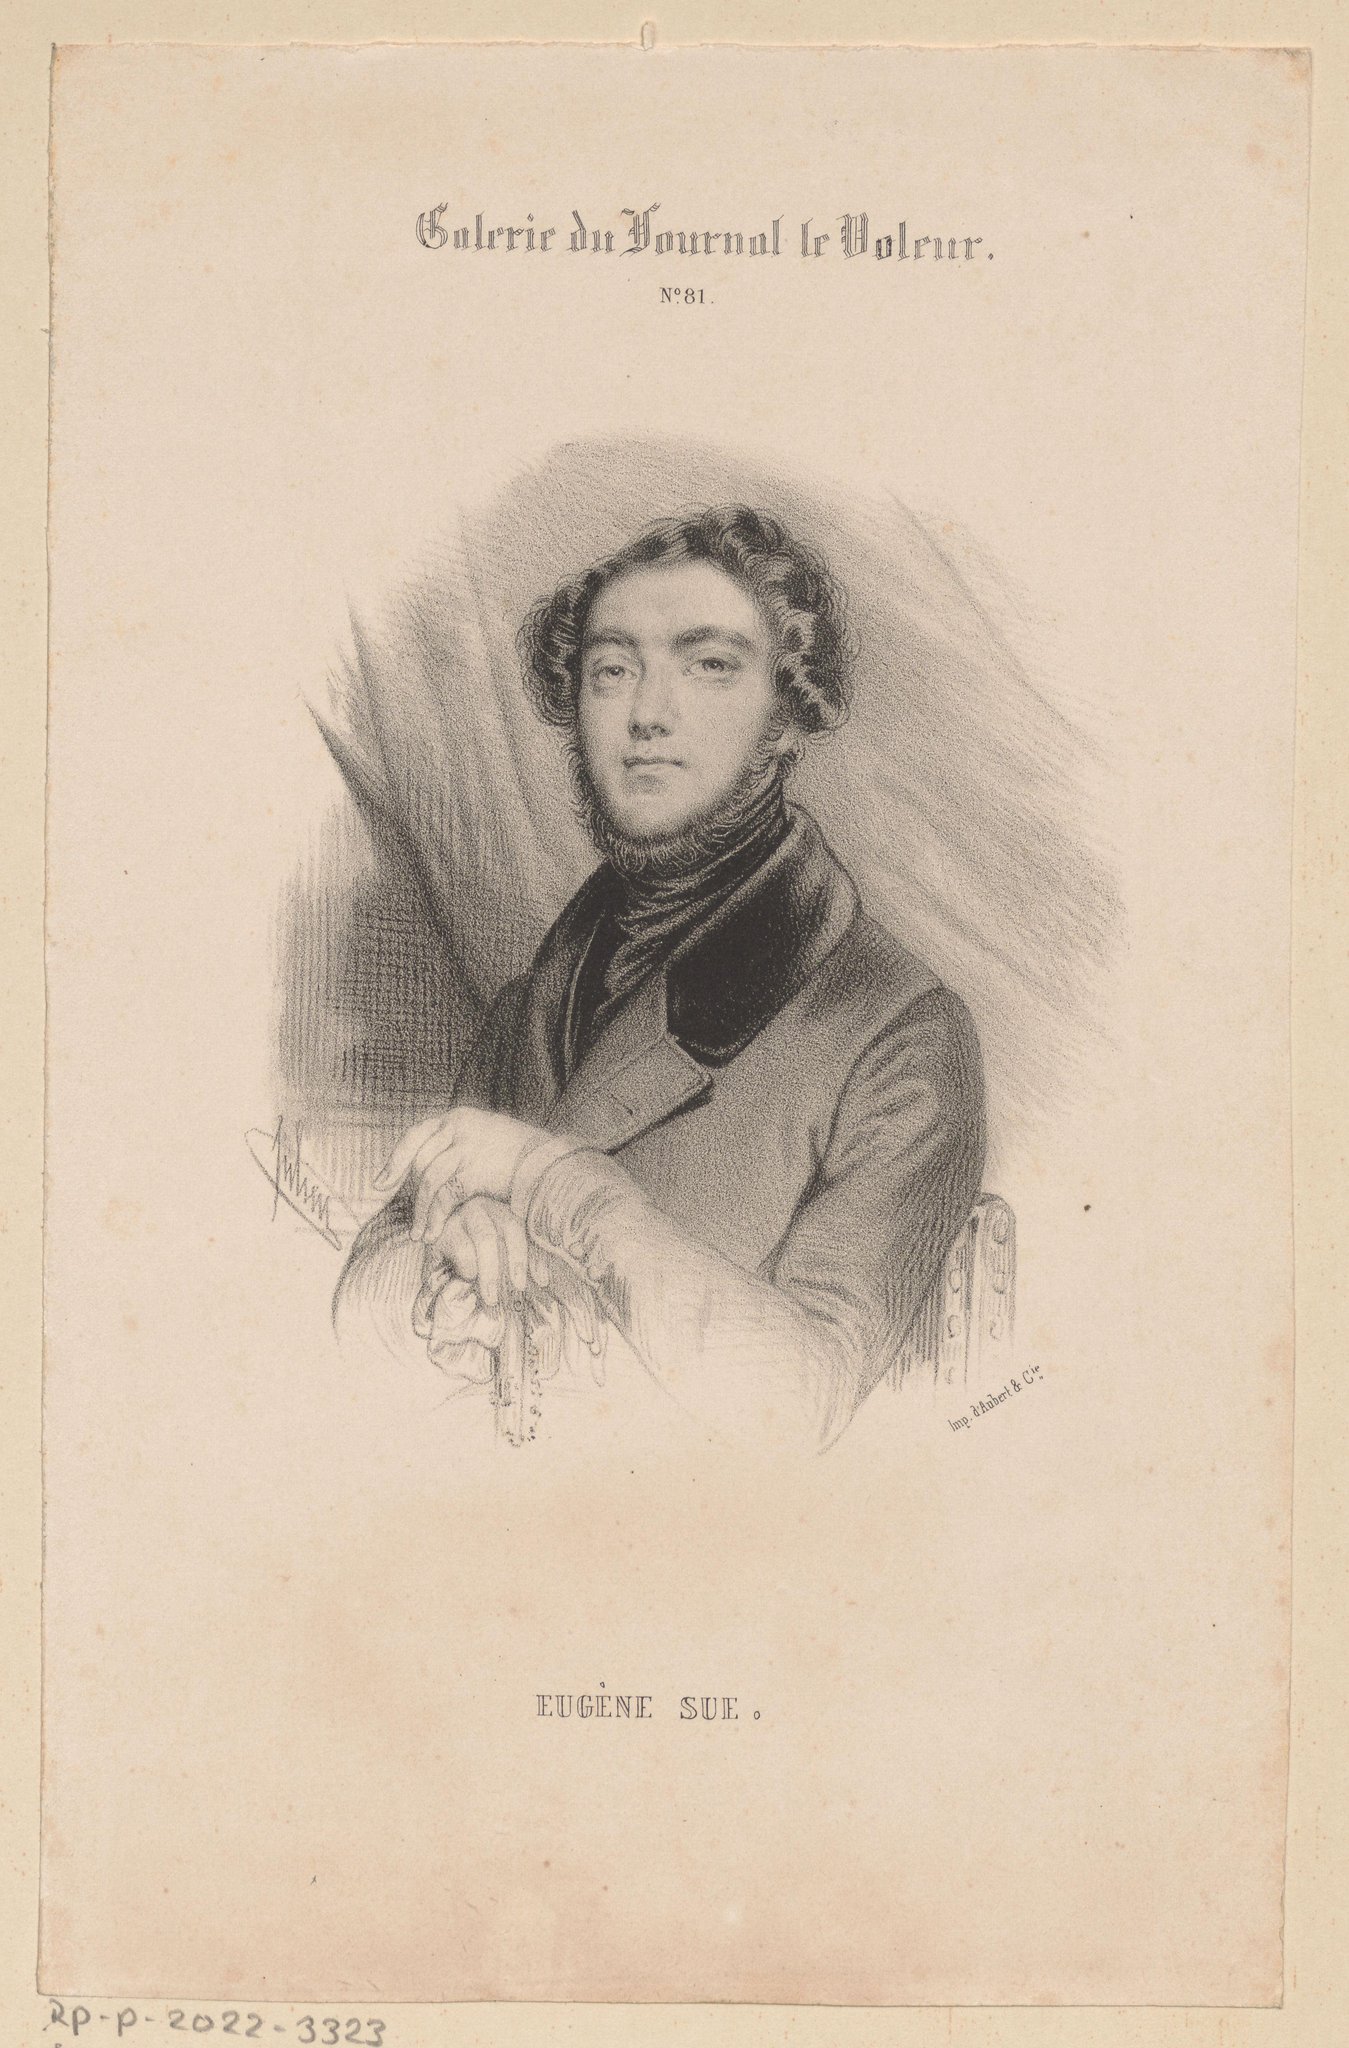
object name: print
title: Portrettengalerij van Le Voleur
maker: bernard romain julien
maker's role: print maker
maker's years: 1802-1871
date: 1841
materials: paper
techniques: lithograph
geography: paris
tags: historical persons, portrait of a writer